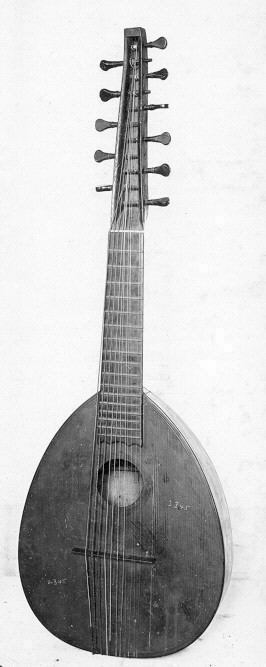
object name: arch cittern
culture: french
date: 1767-1800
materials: wood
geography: france